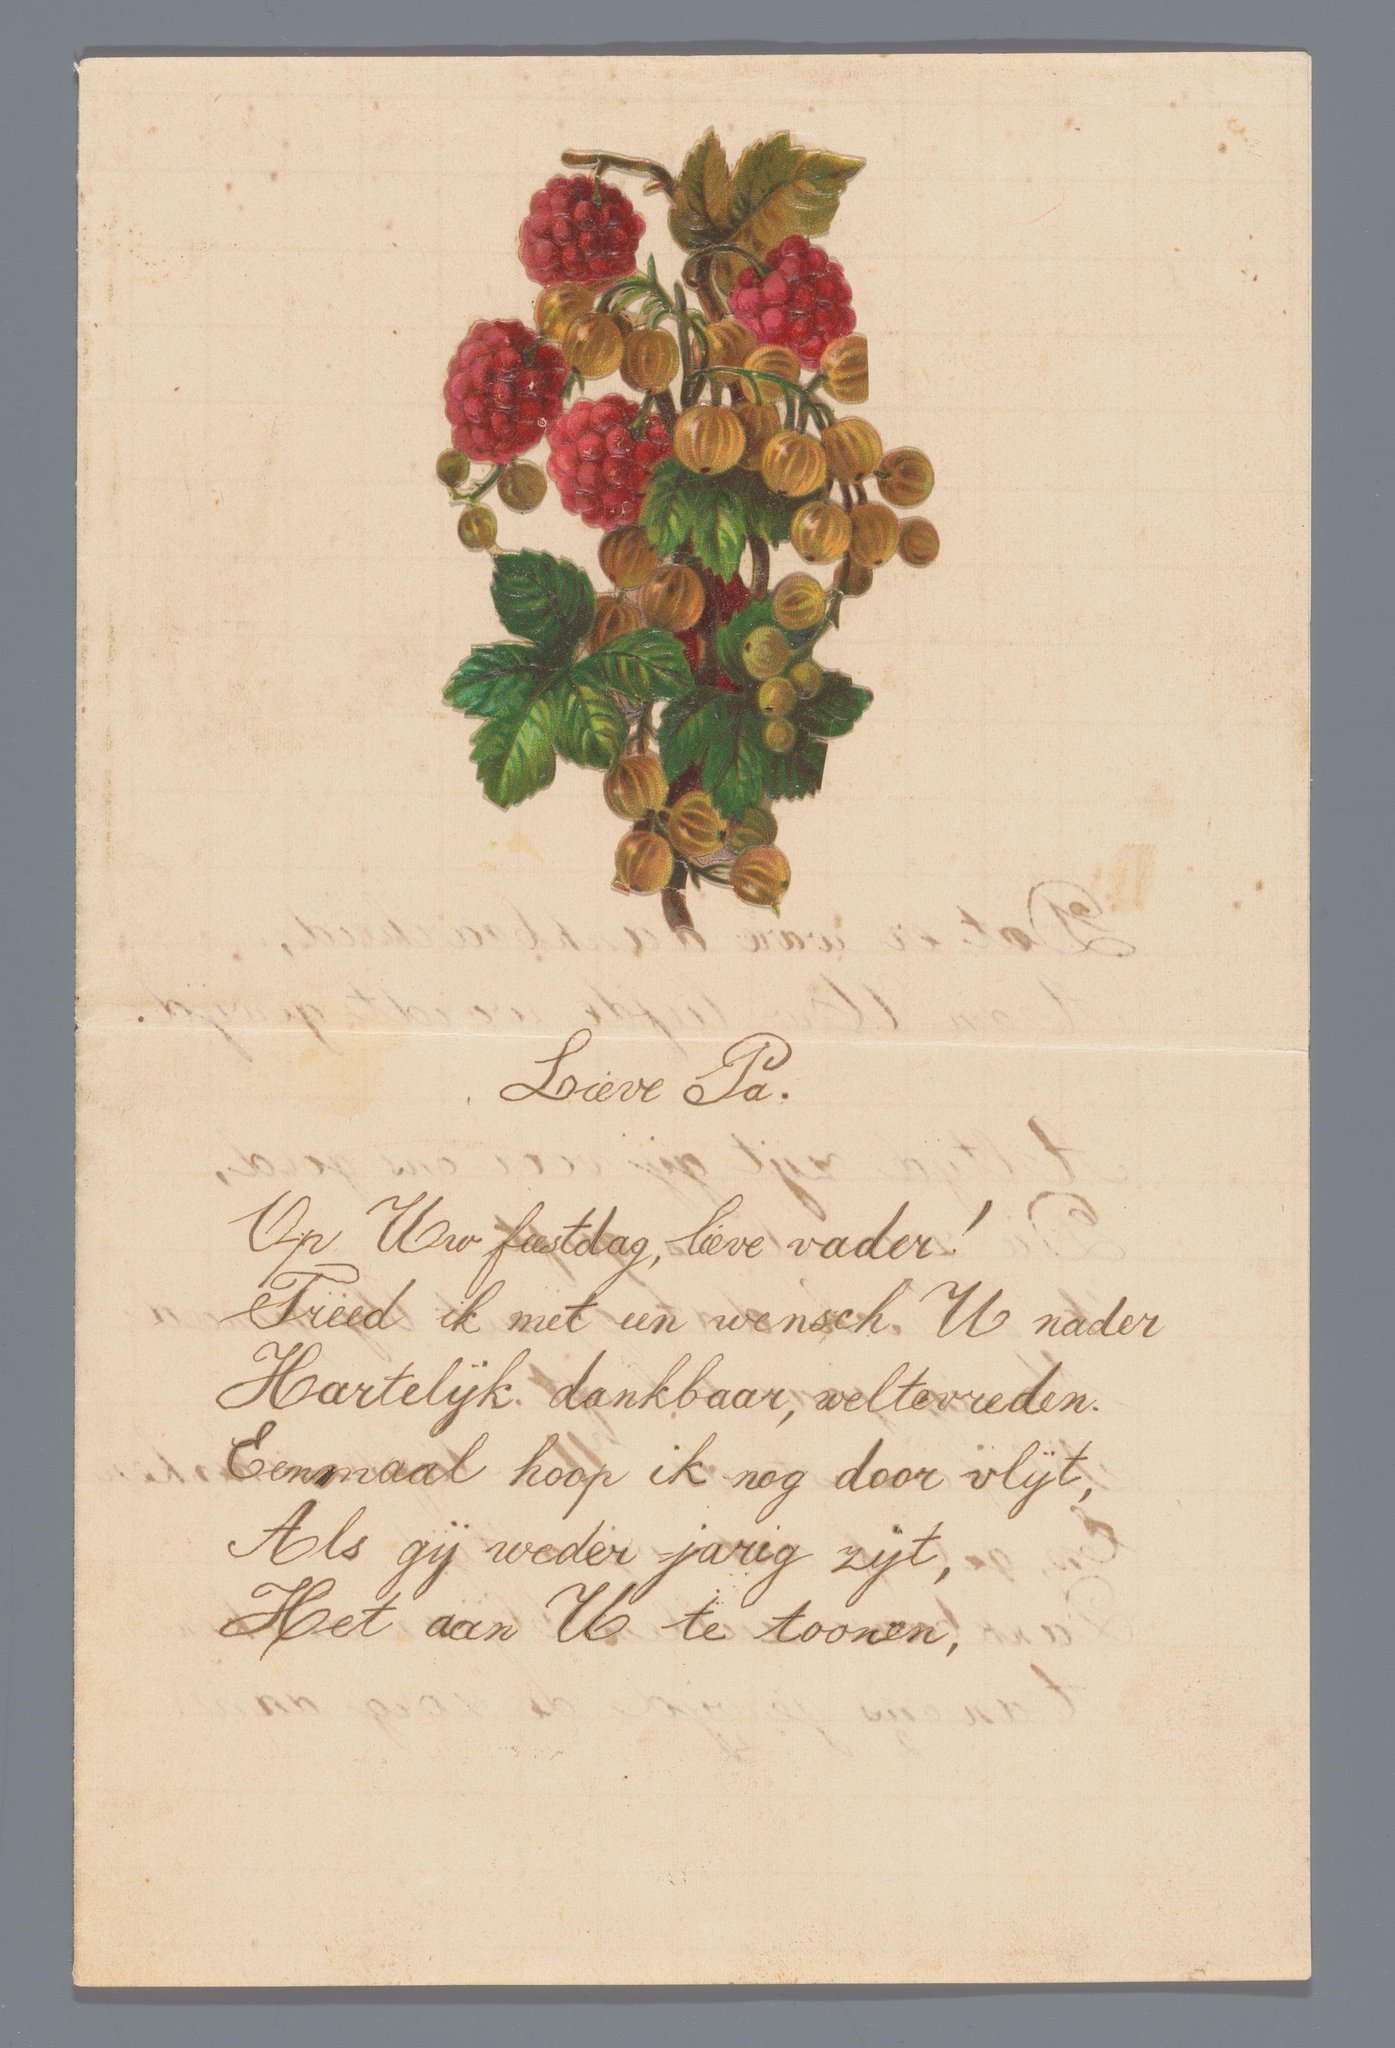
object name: document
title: Verjaardagsgedicht van mevrouw van Delden-Ament (geboren 1869) aan haar vader J.A. Ament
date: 1879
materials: paper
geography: dutch east indies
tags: justine van beusechem, van delden-ament, buitenzorg, bandung, jan abraham ament, mojokerto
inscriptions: date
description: Verjaardagsgedicht met een poësieplaatje erop van Justien aan haar vader. Gedateerd en ondertekend.